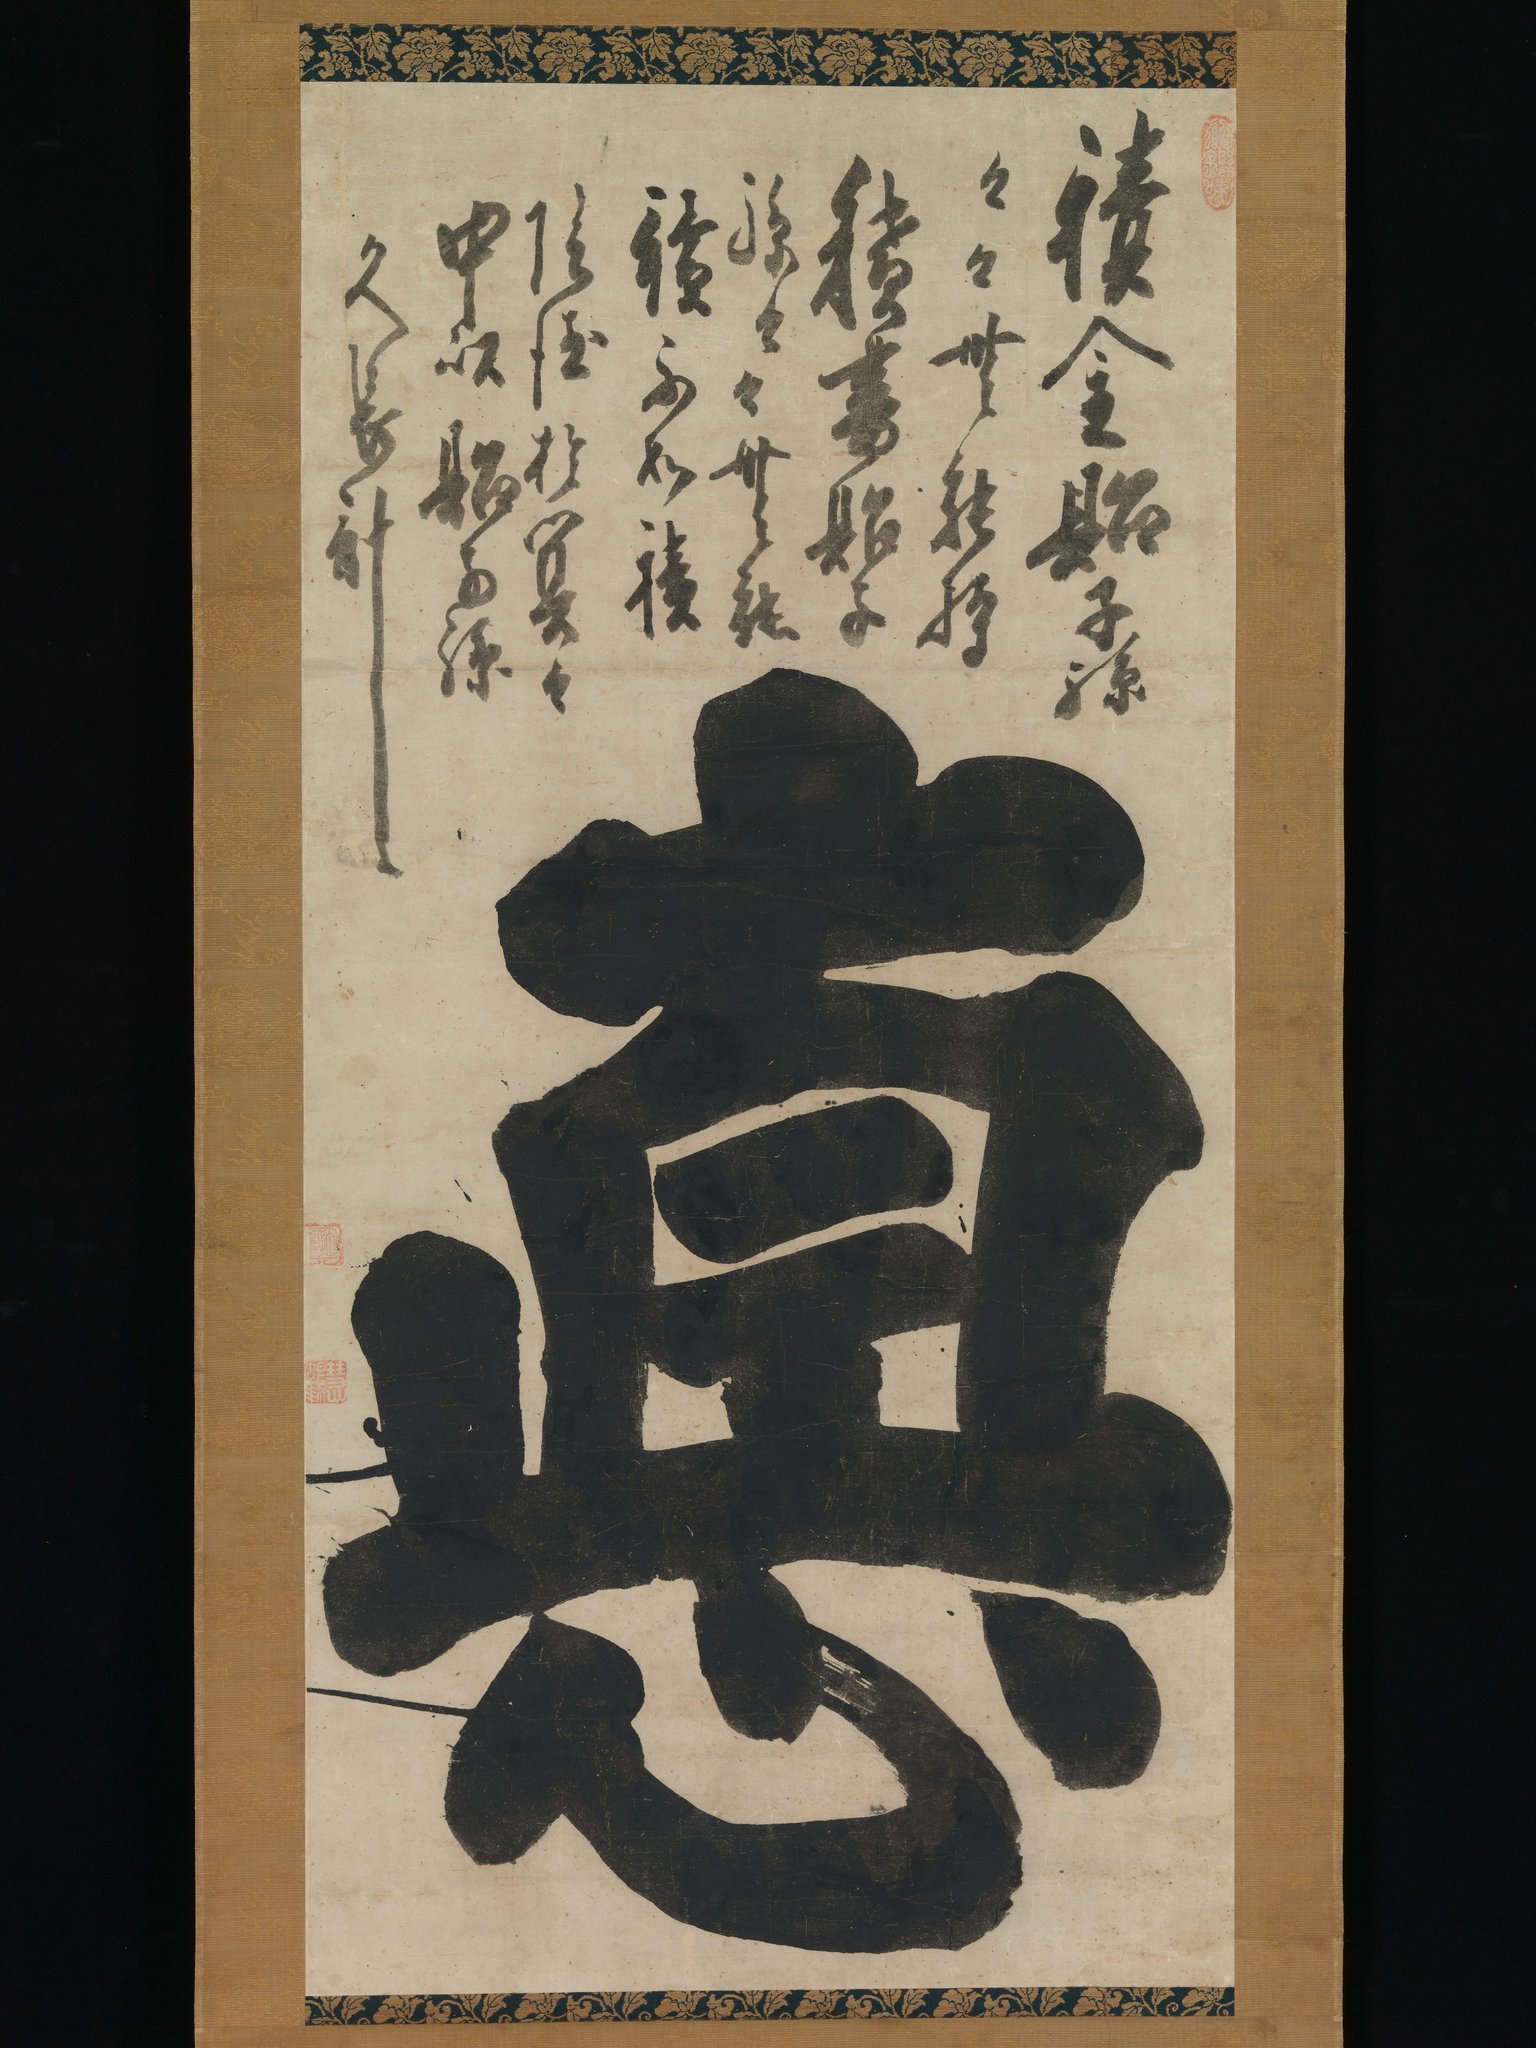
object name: hanging scroll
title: "Virtue"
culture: japanese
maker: hakuin ekaku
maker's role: artist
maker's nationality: japanese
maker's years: 1686-1769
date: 1734-1766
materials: ink, paper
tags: calligraphy